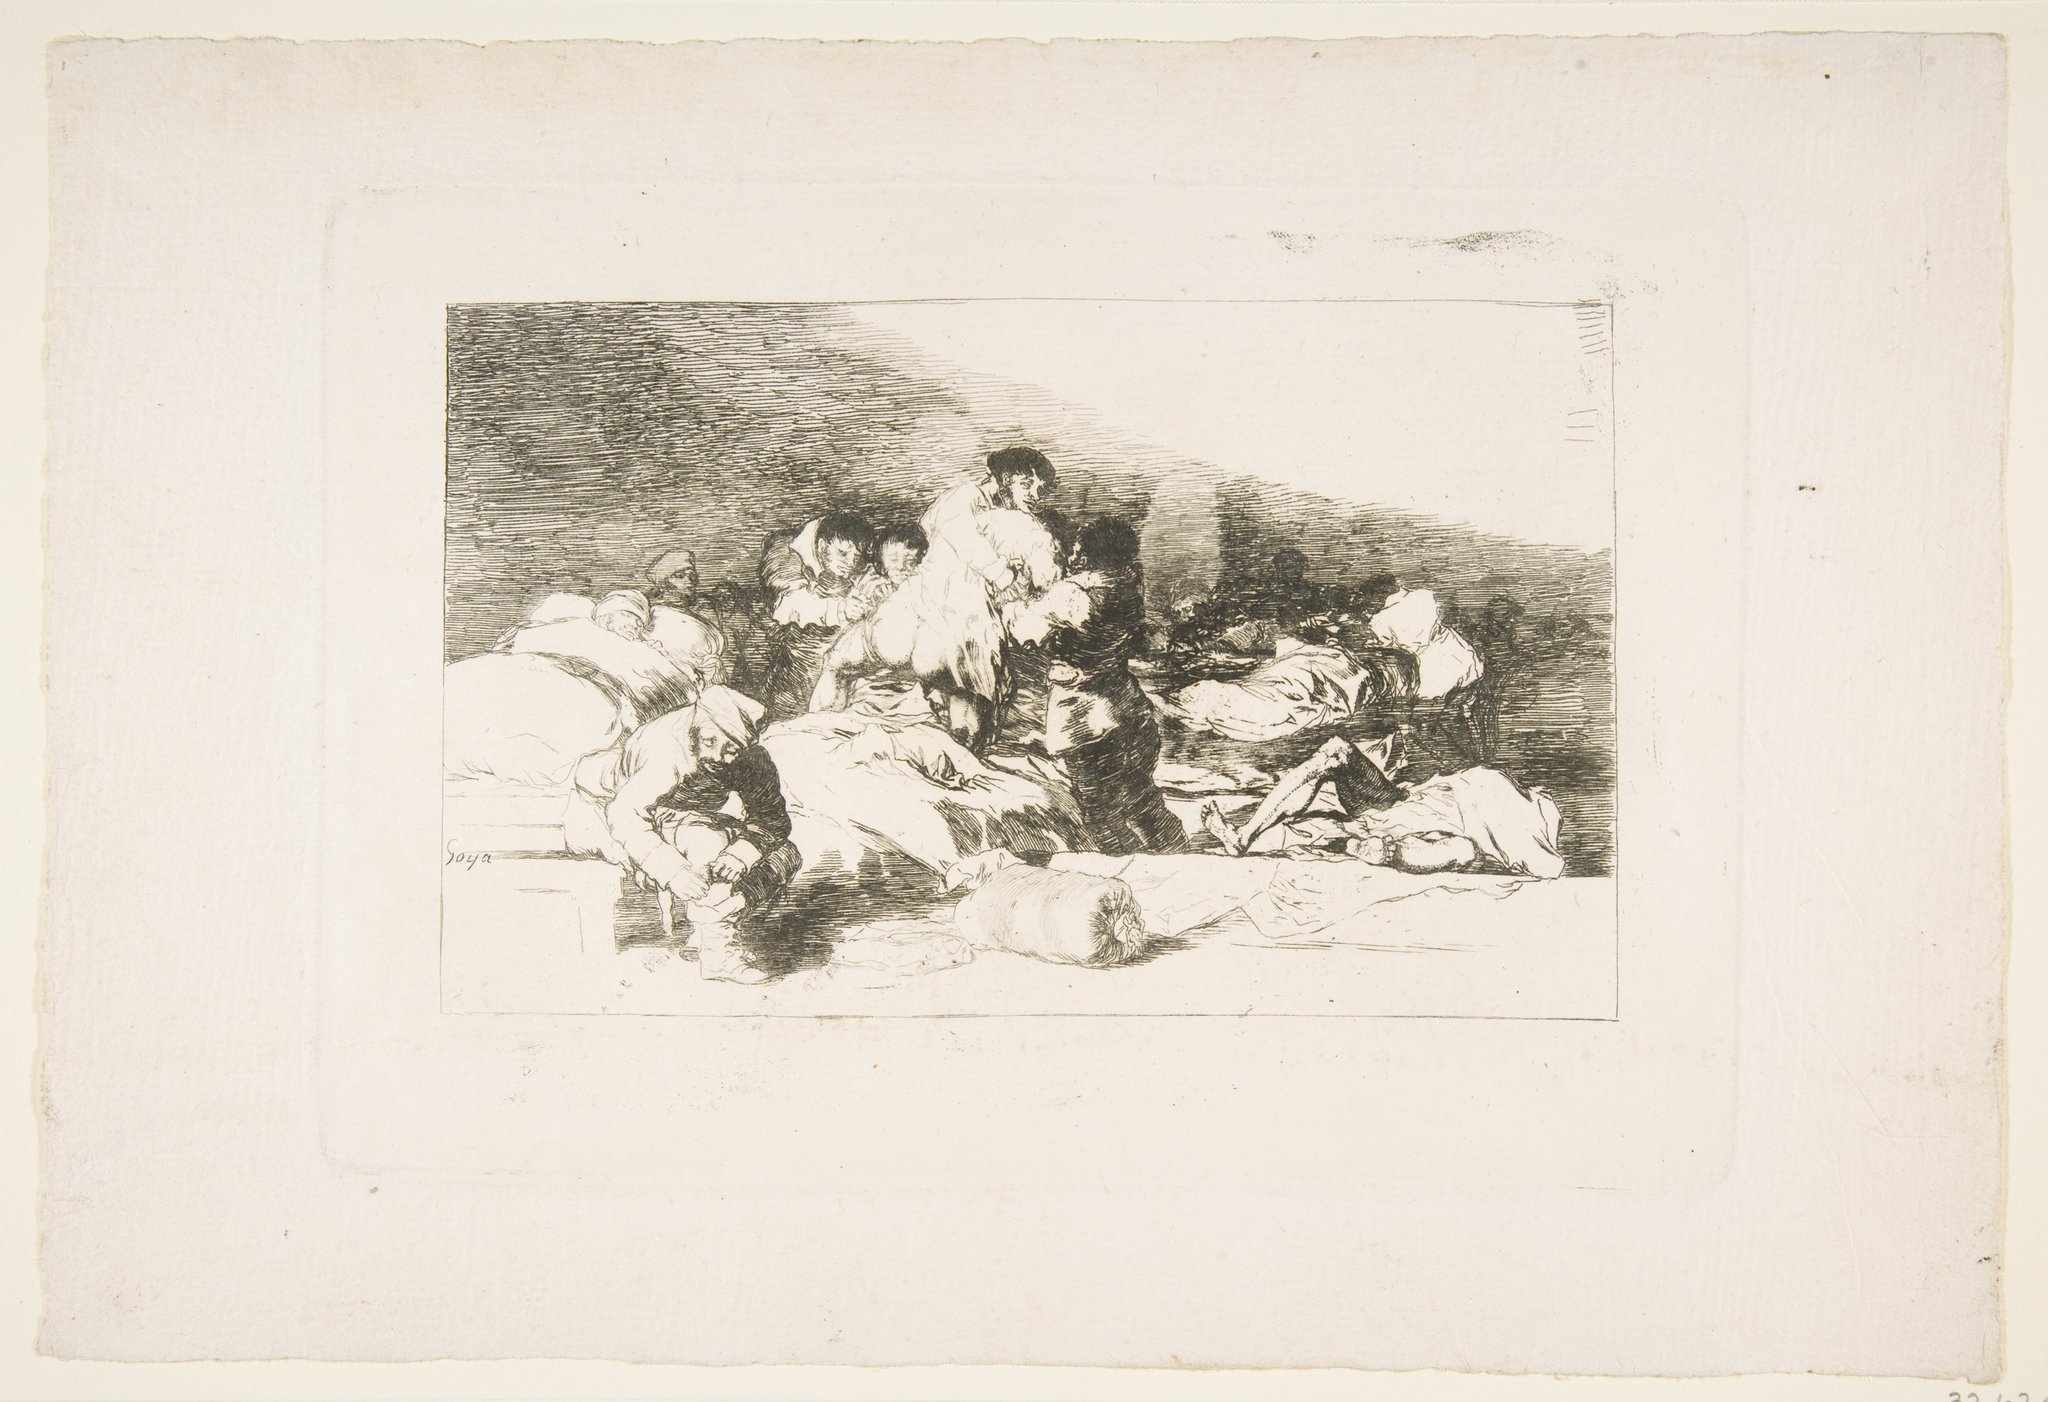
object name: print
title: Plate 25 from "The Disasters of War" (Los Desastres de la Guerra): 'These too' (Tambien estos)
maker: goya (francisco de goya y lucientes)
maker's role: artist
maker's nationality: spanish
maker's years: 1746-1828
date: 1810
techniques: engraving, drypoint, etching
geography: spain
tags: suffering,men